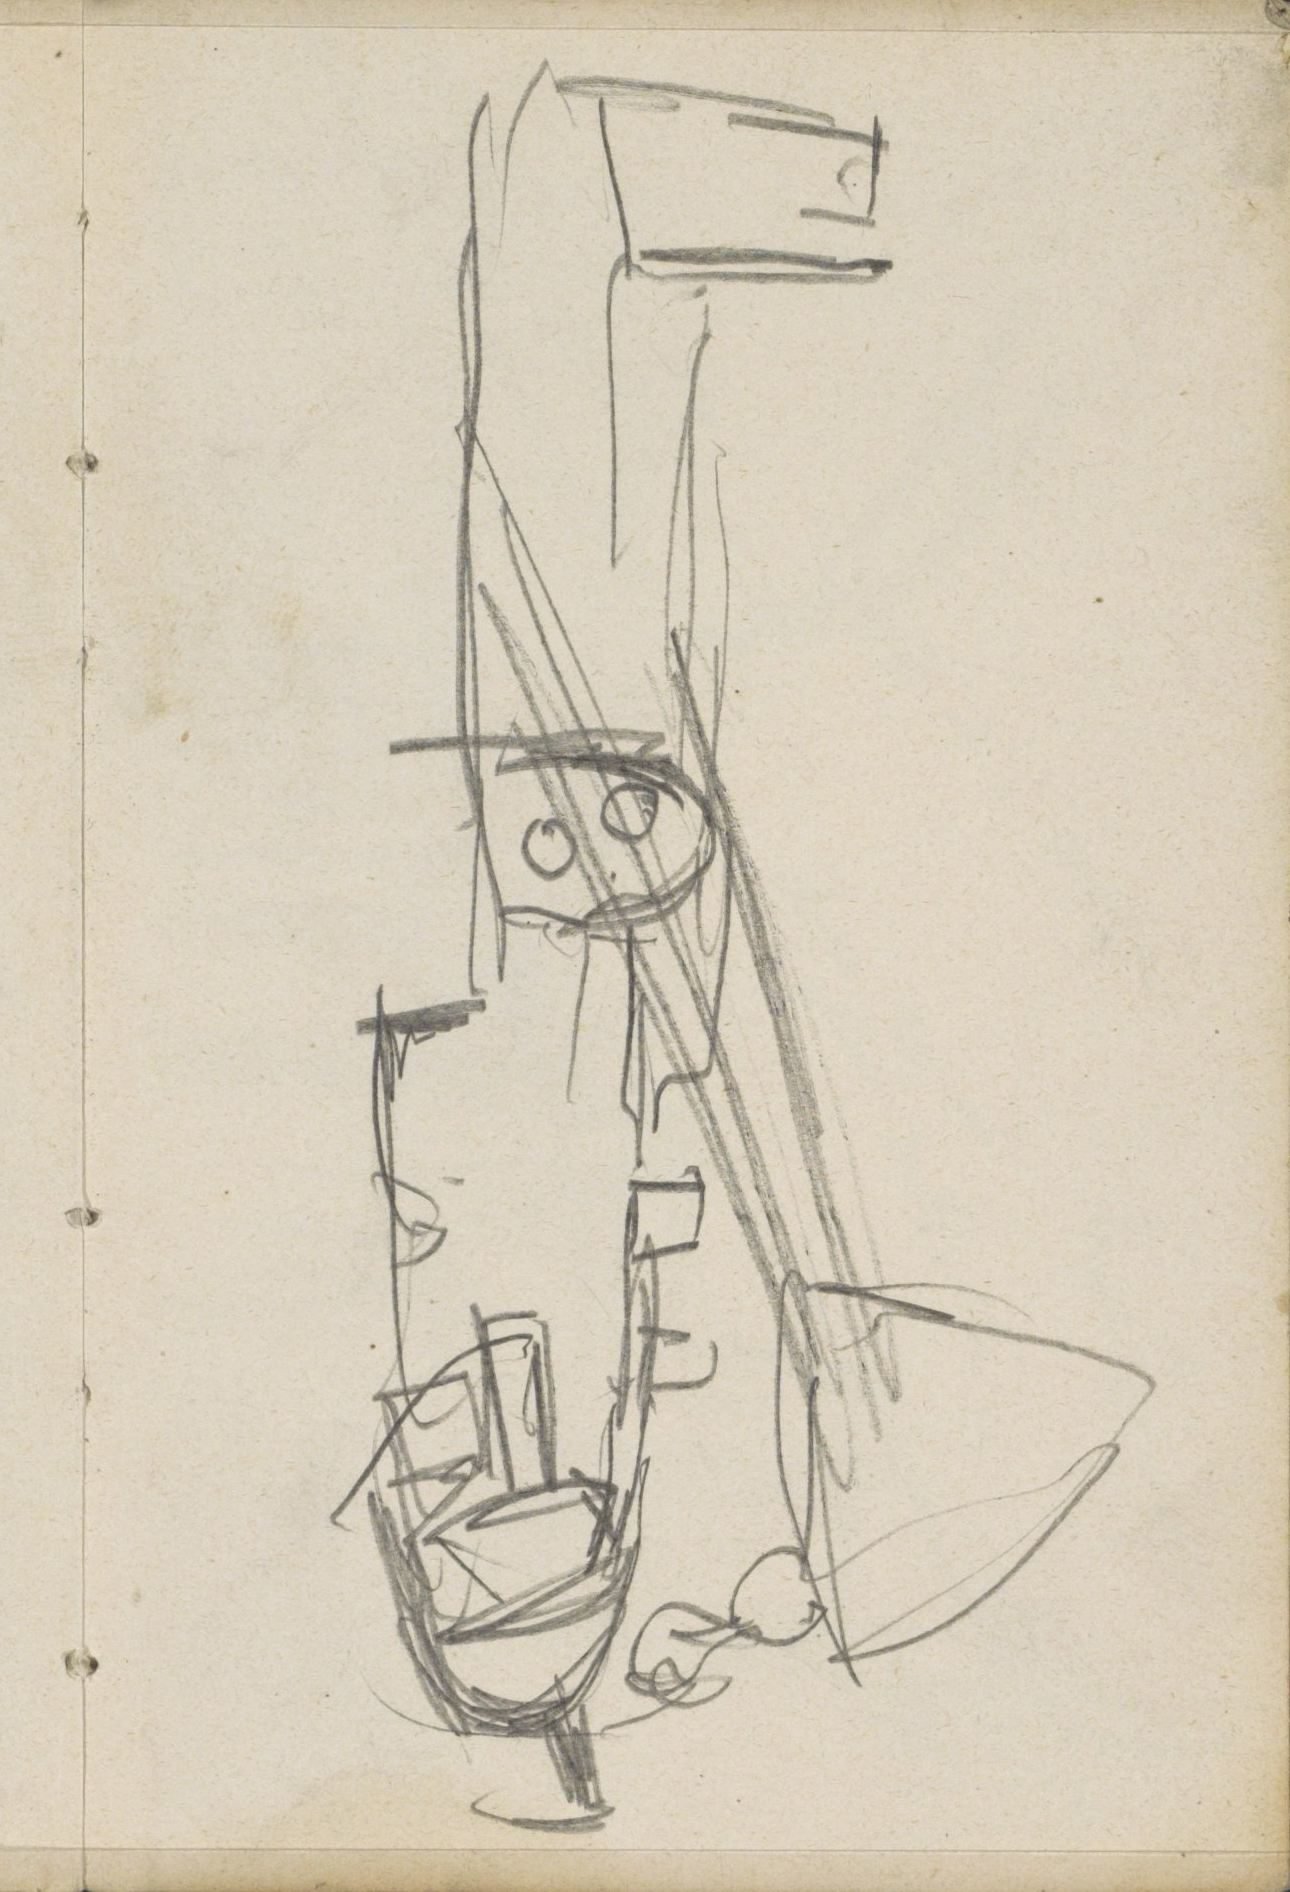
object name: sketchbook leaf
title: Voorsteven van een schuit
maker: george hendrik breitner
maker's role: draughtsman, painter, print maker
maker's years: 1857-1923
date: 1892-1923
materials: paper, pencil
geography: amsterdam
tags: ships (in general)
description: Voorsteven van een schuit. Pagina 85 uit een schetsboek met 45 bladen vervaardigd te Schwerin en Amsterdam.